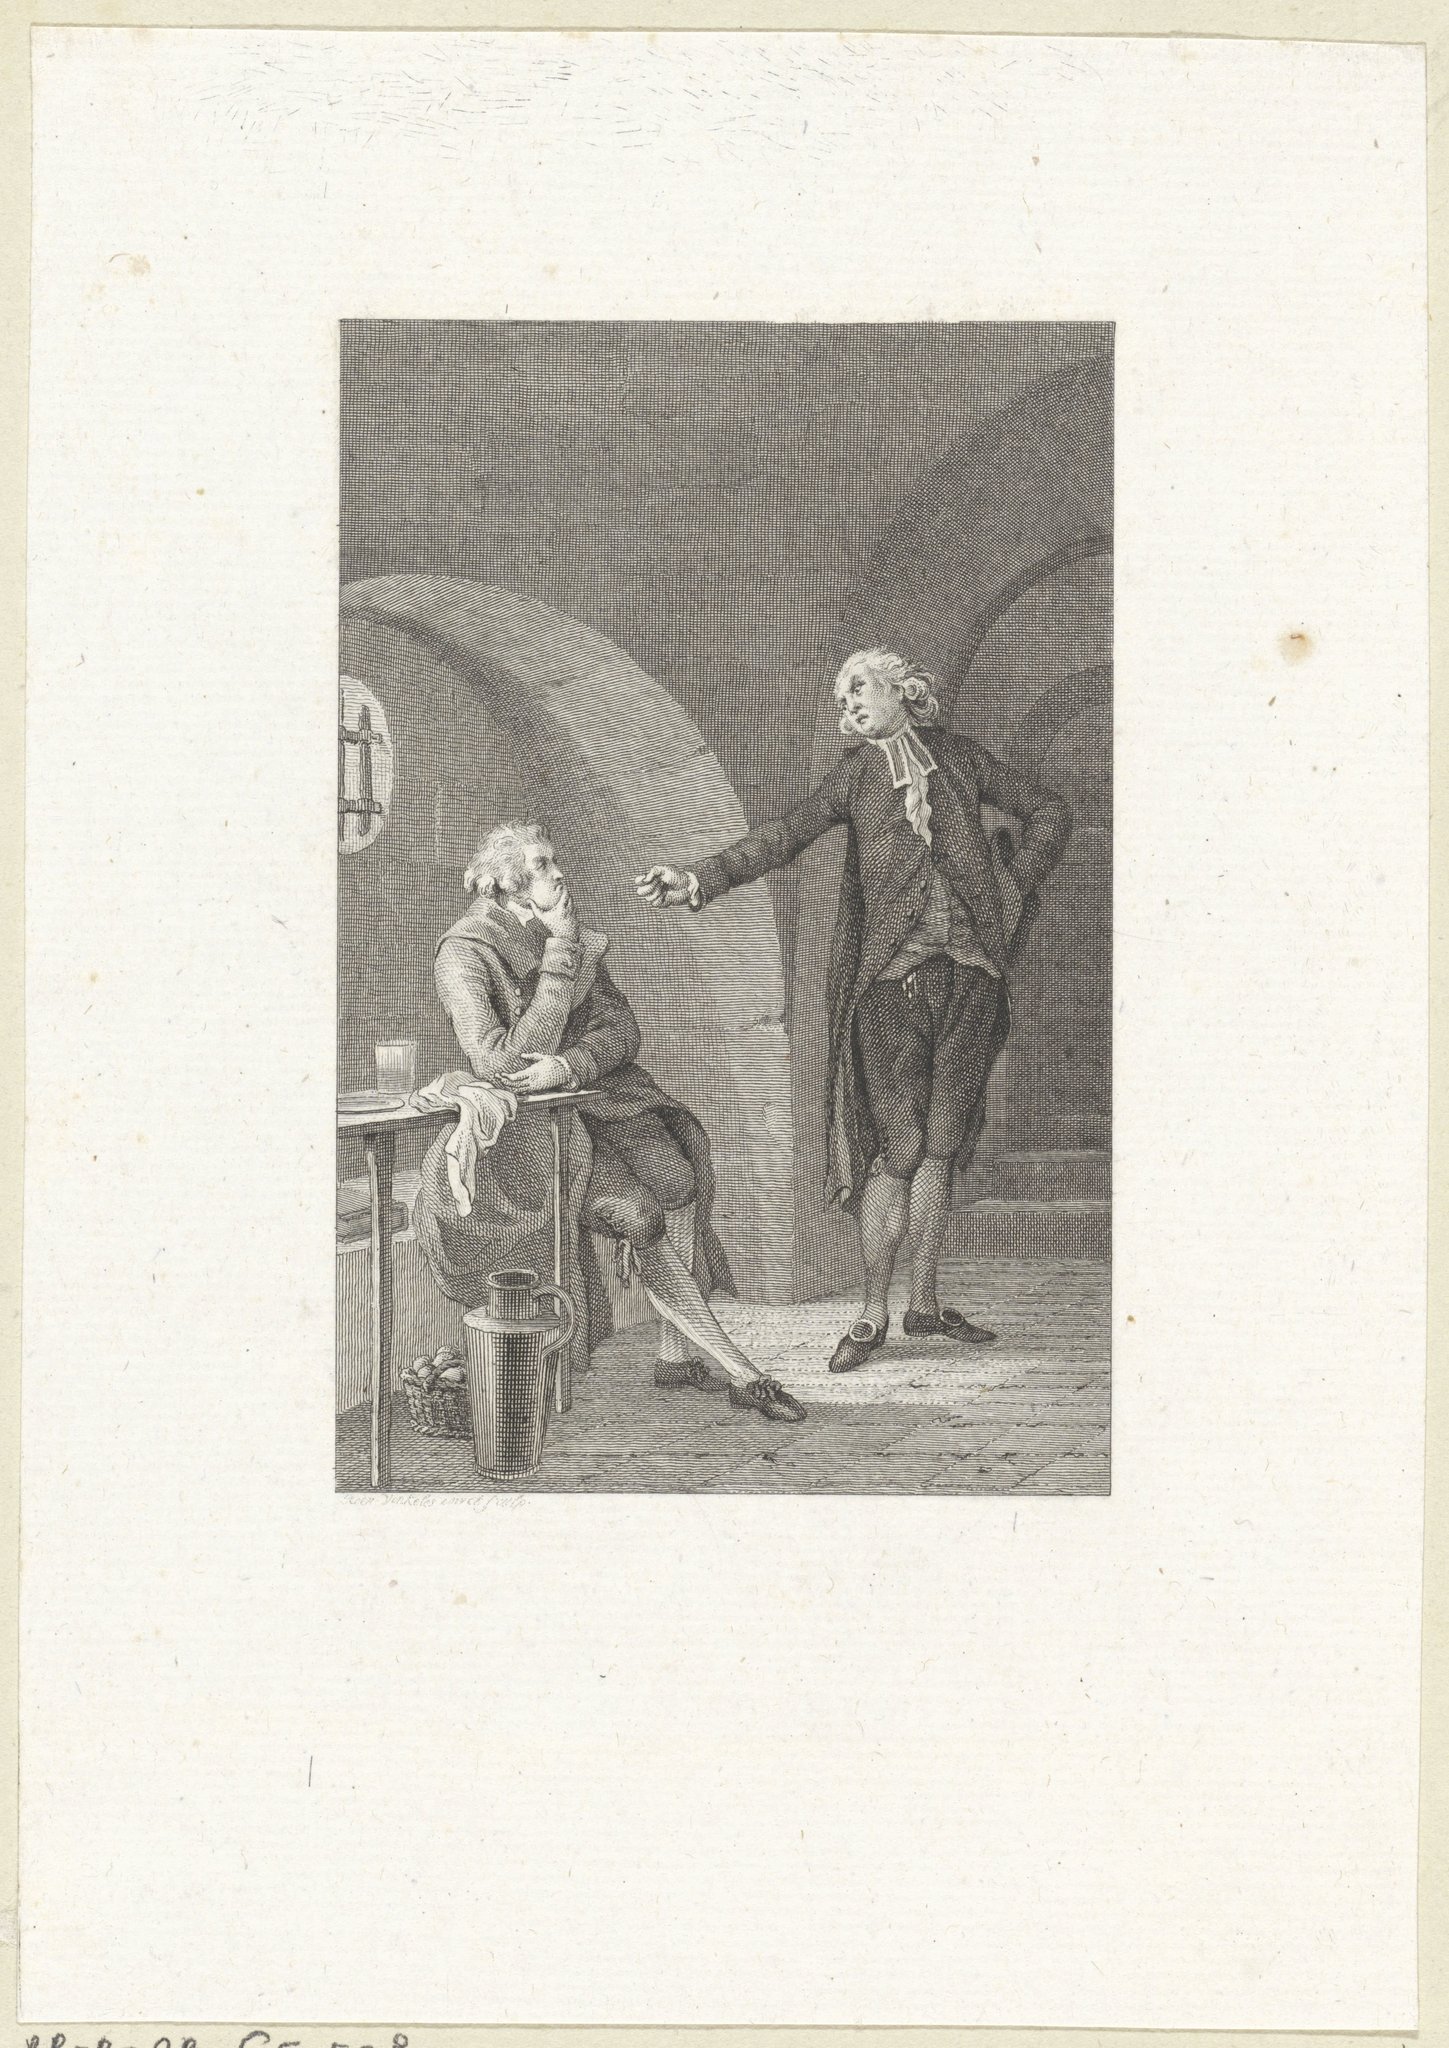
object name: print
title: Man noemt een andere man ondankbaar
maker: reinier vinkeles (i)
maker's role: draughtsman, print maker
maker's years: 1741-1816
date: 1796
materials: paper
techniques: engraving, etching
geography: amsterdam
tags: conflict; 'contrasto' (ripa) (+ variant), hand made into a fist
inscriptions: collector's mark: Lugt 240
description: Proefdruk van een prent die mogelijk ook gebruikt is als illustratie in: Snoodheid gestraft, deugd beloond. Amsterdam: erven van Pieter Meĳer en Gerrit Warnars, 1796.